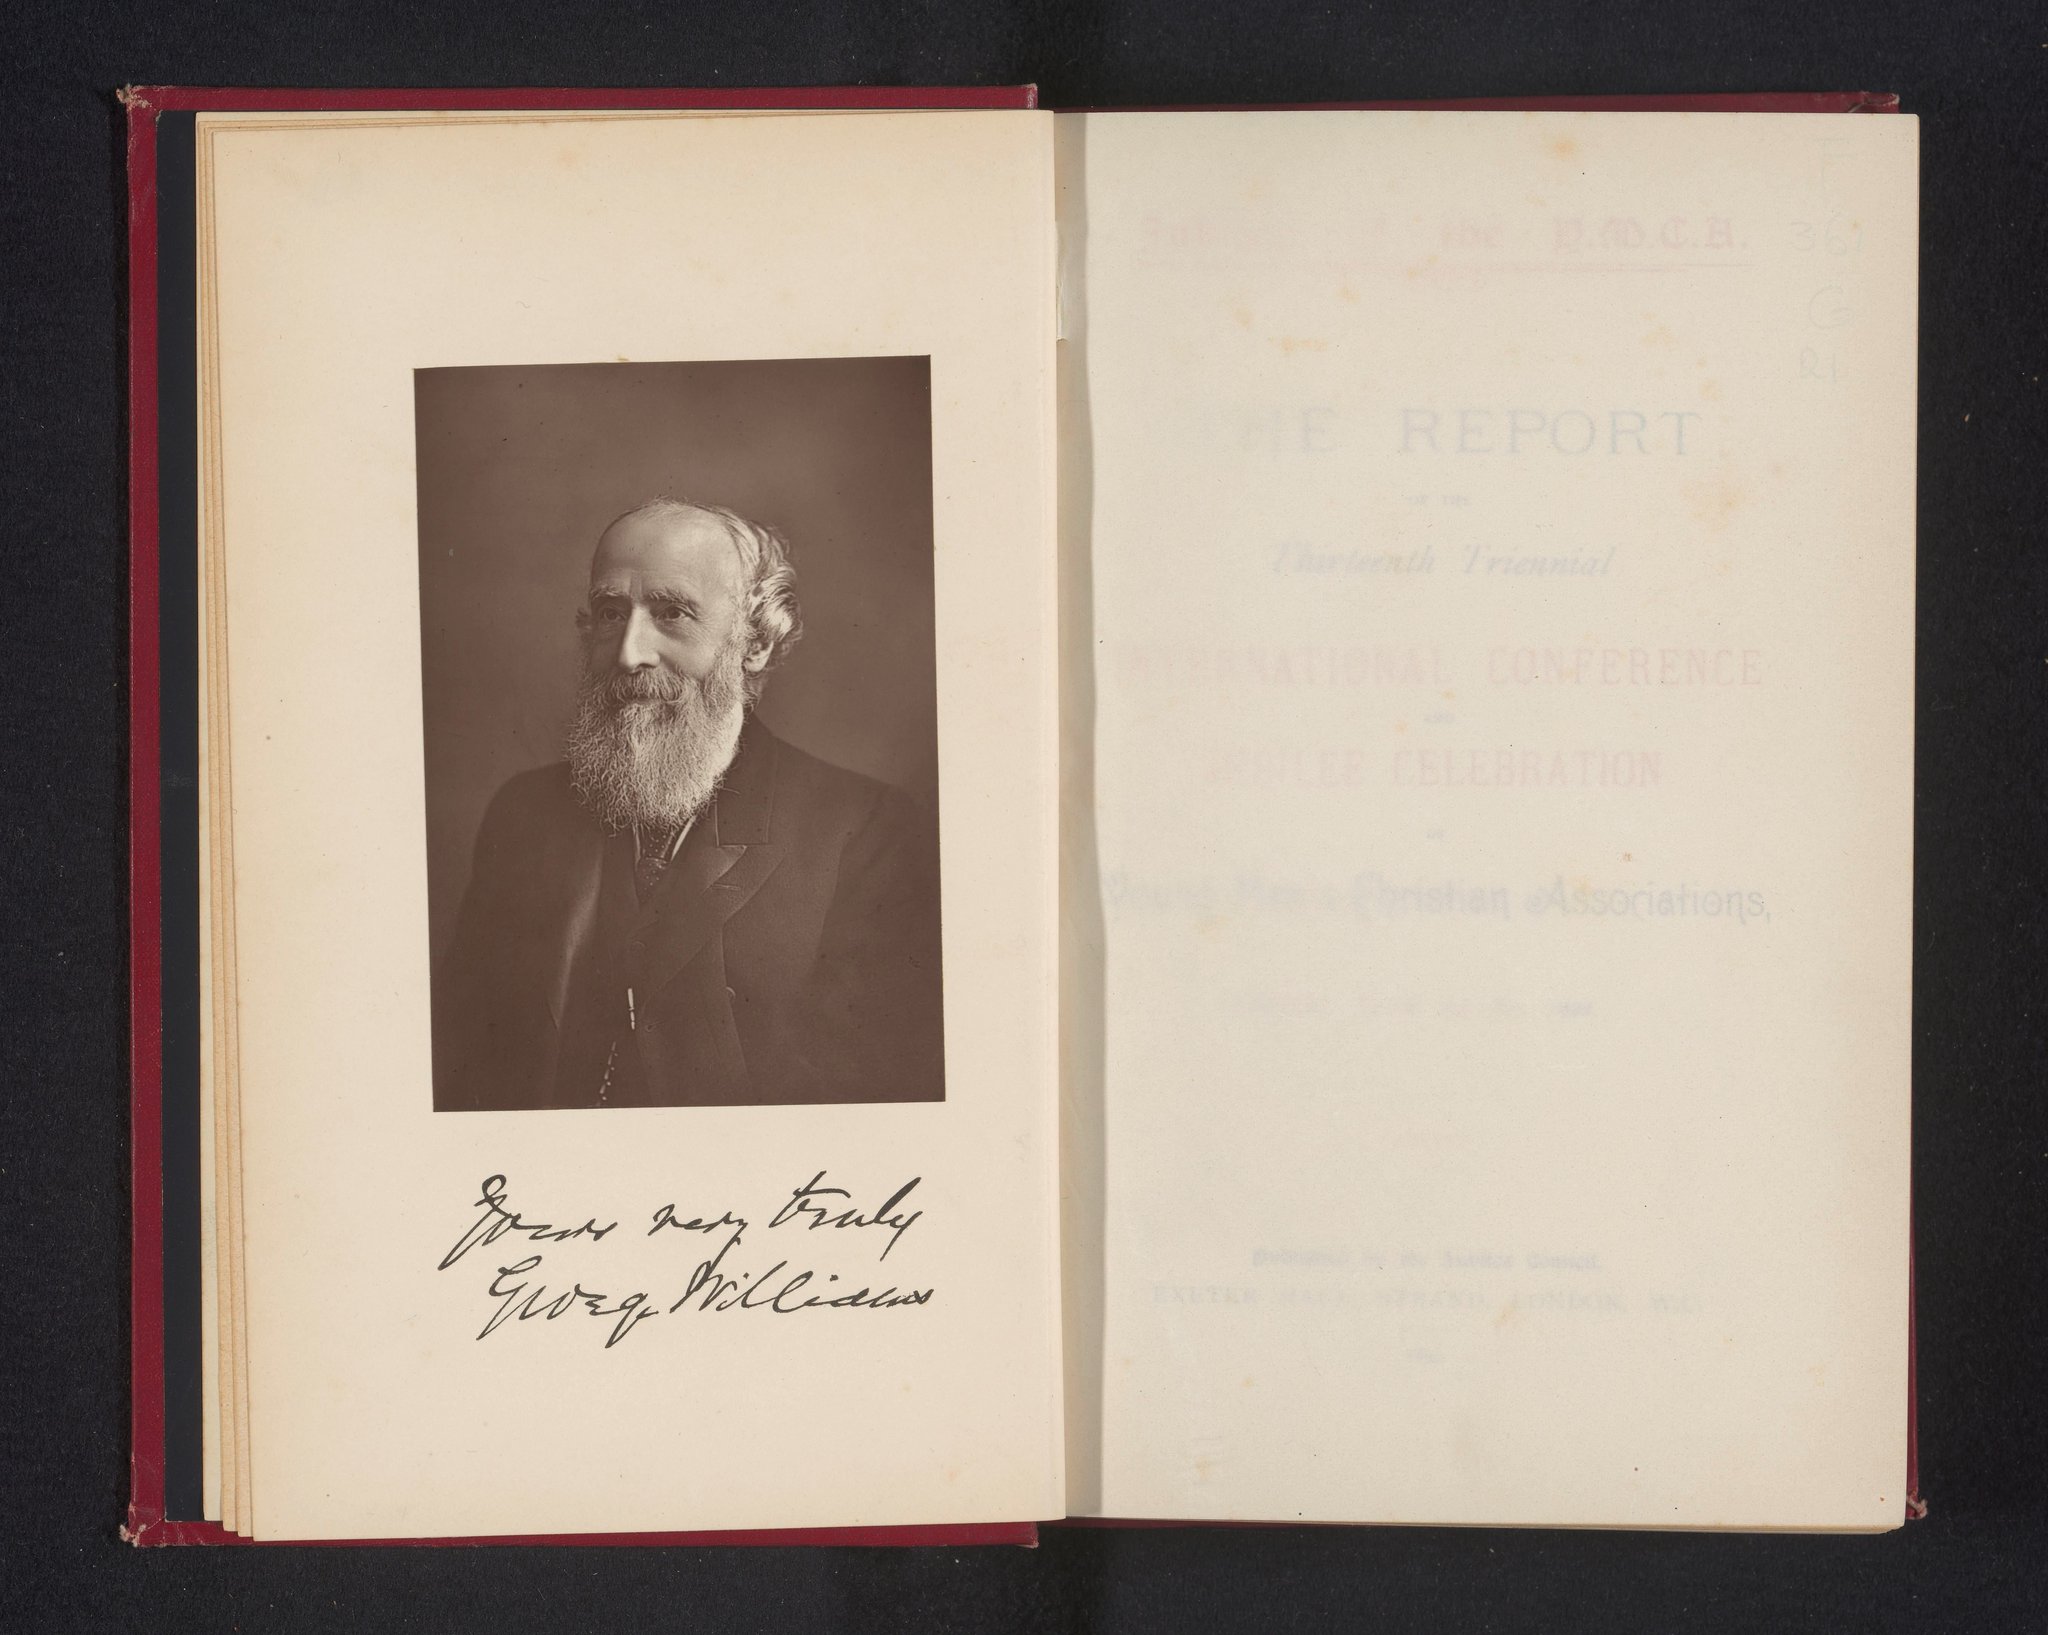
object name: page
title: Portret van George Williams, oprichter van de Young Men's Christian Associations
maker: Anonymous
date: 1890-1895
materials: paper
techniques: woodburytype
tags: london, historical persons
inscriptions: dedication: ‘Yours very truly/ George Williams’